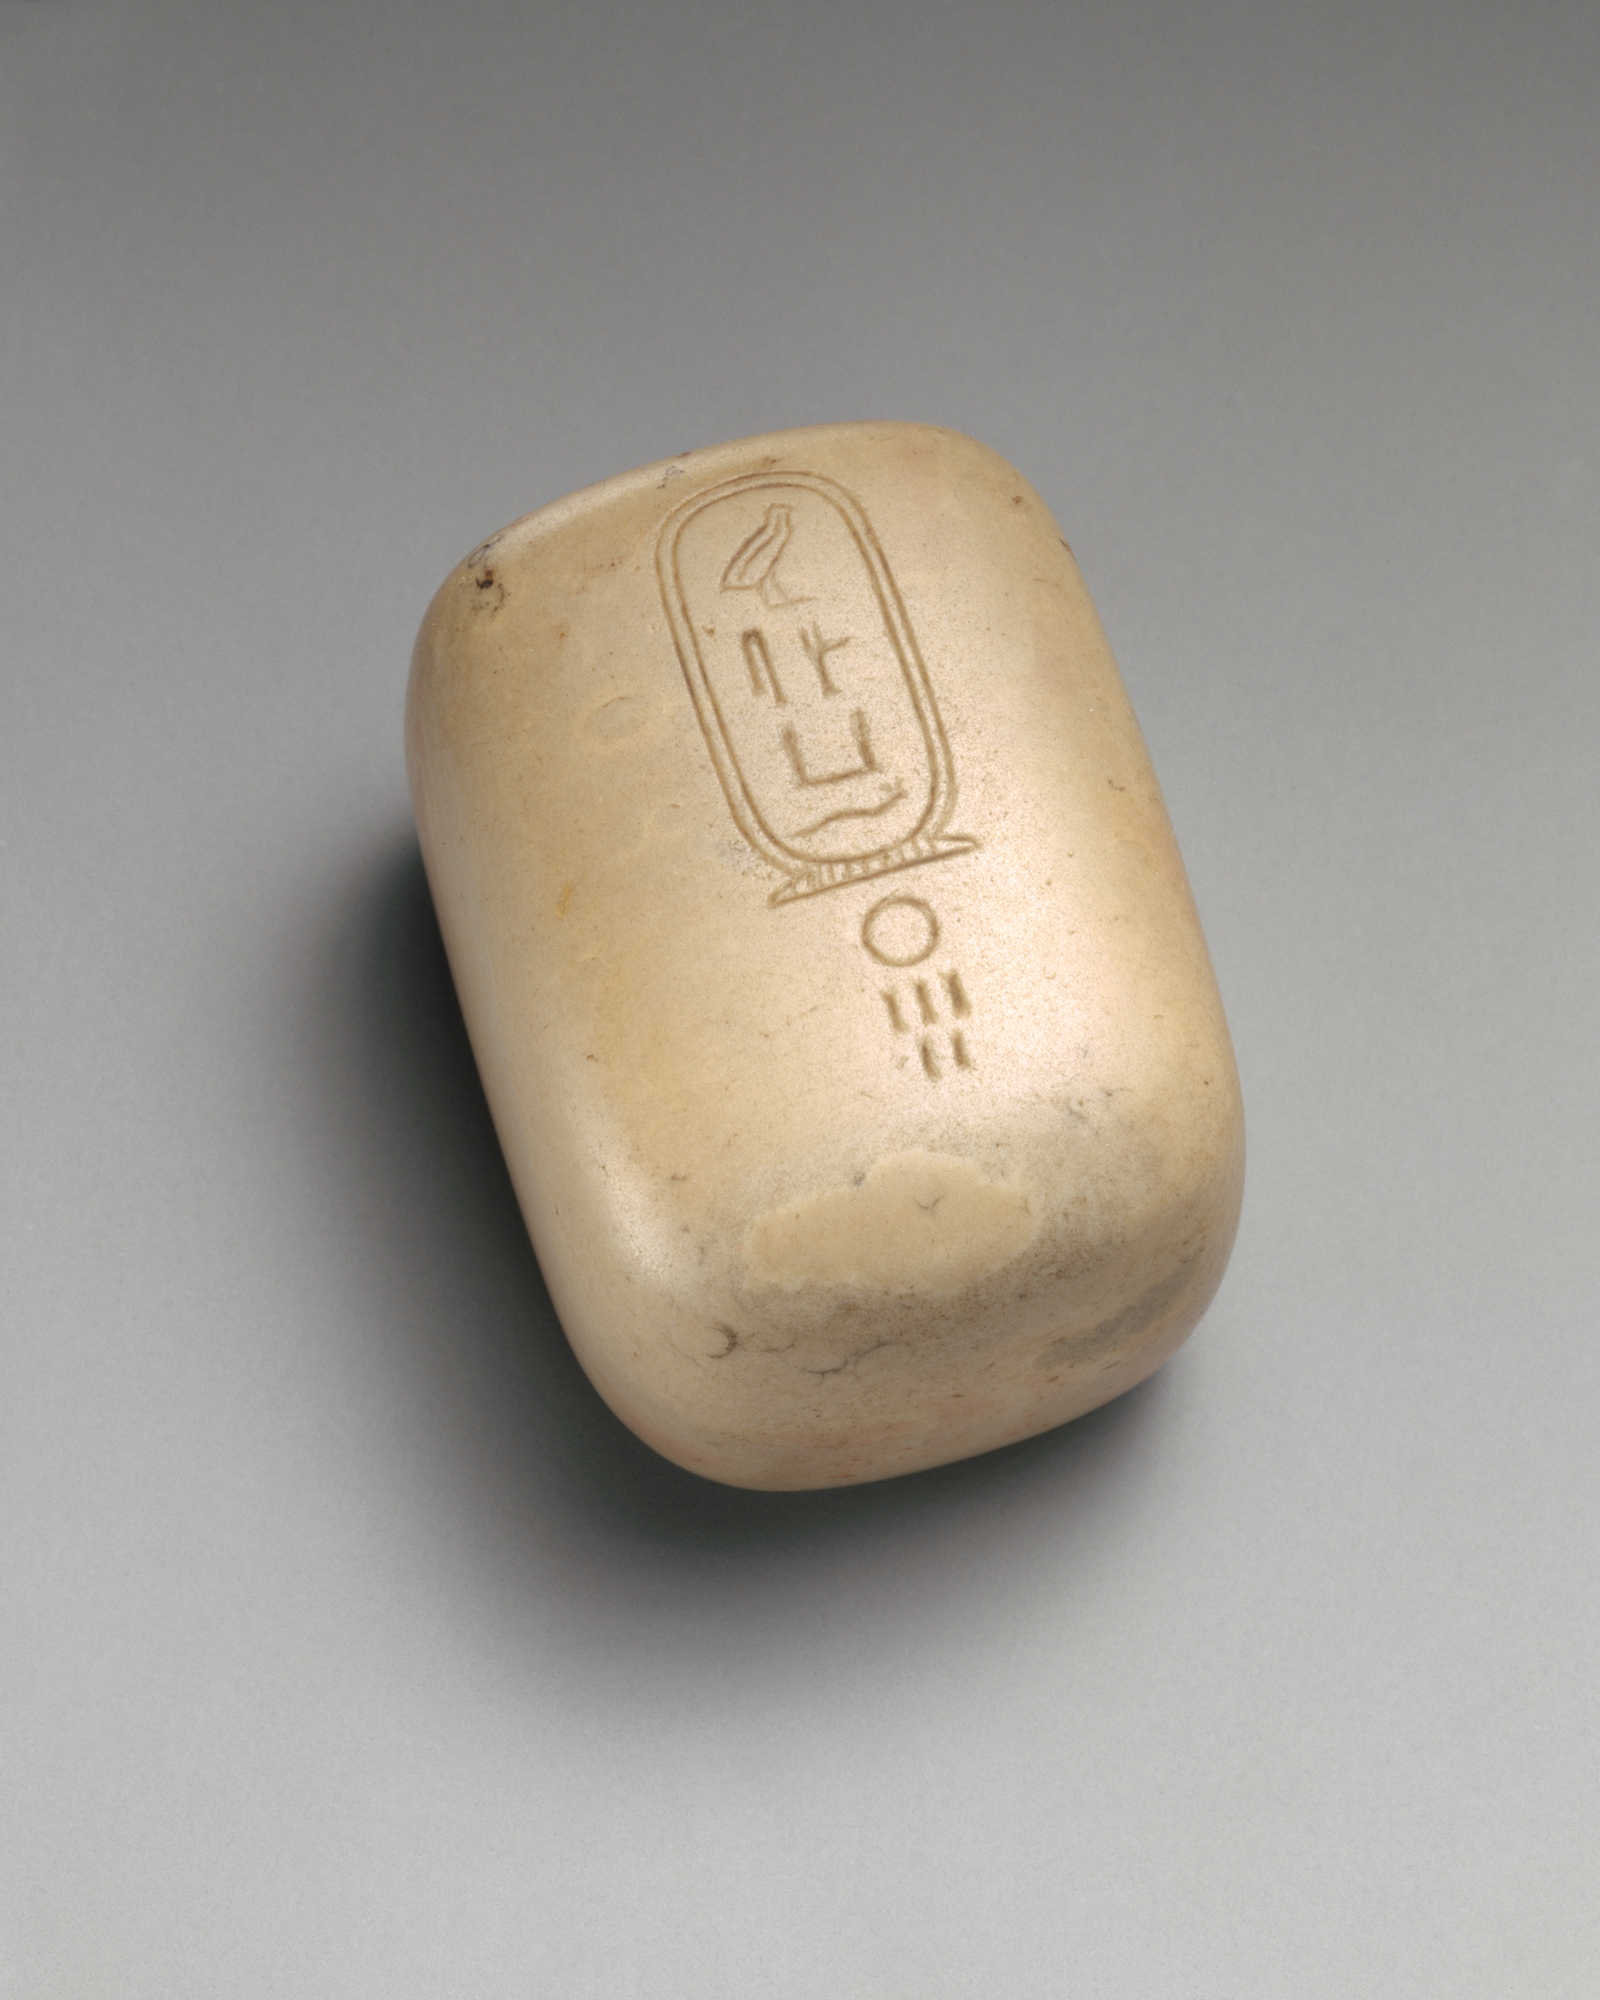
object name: weight, 5 deben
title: Weight equal to five deben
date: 2649-2100 BCE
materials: jasper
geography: egypt